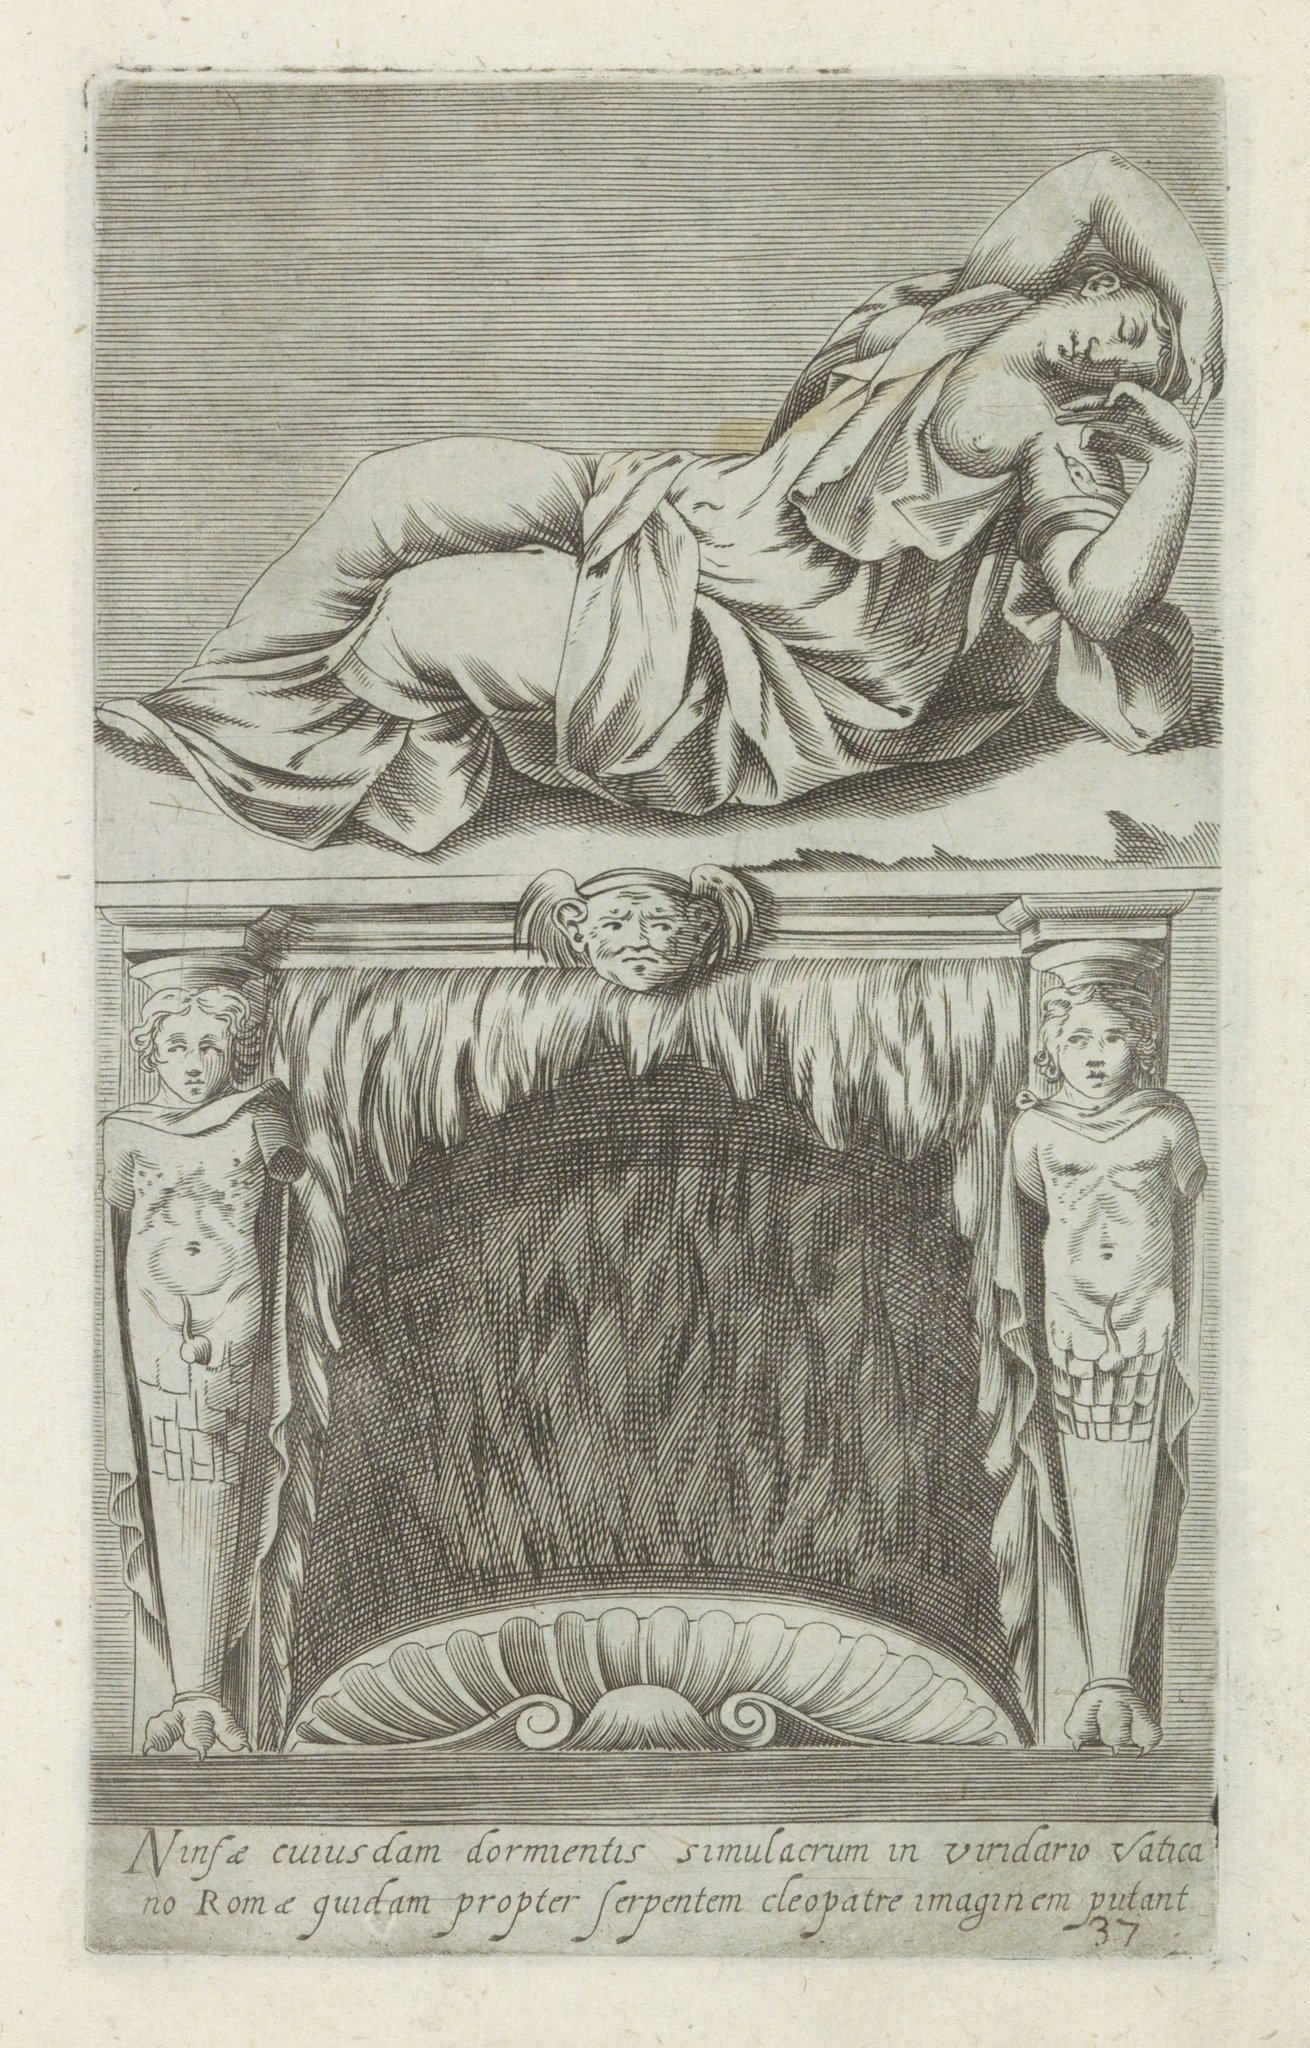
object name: album leaf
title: Antieke sculpturen in Rome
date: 1584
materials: paper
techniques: engraving, intaglio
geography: rome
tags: (story of) ariadne, piece of sculpture, reproduction of a piece of sculpture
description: Naar een beeld in de Vaticaanse Musea te Vaticaanstad. Deze prent maakt deel uit van een set van 79 prenten (+ titelprent) met voorstellingen van antieke sculpturen in Rome.